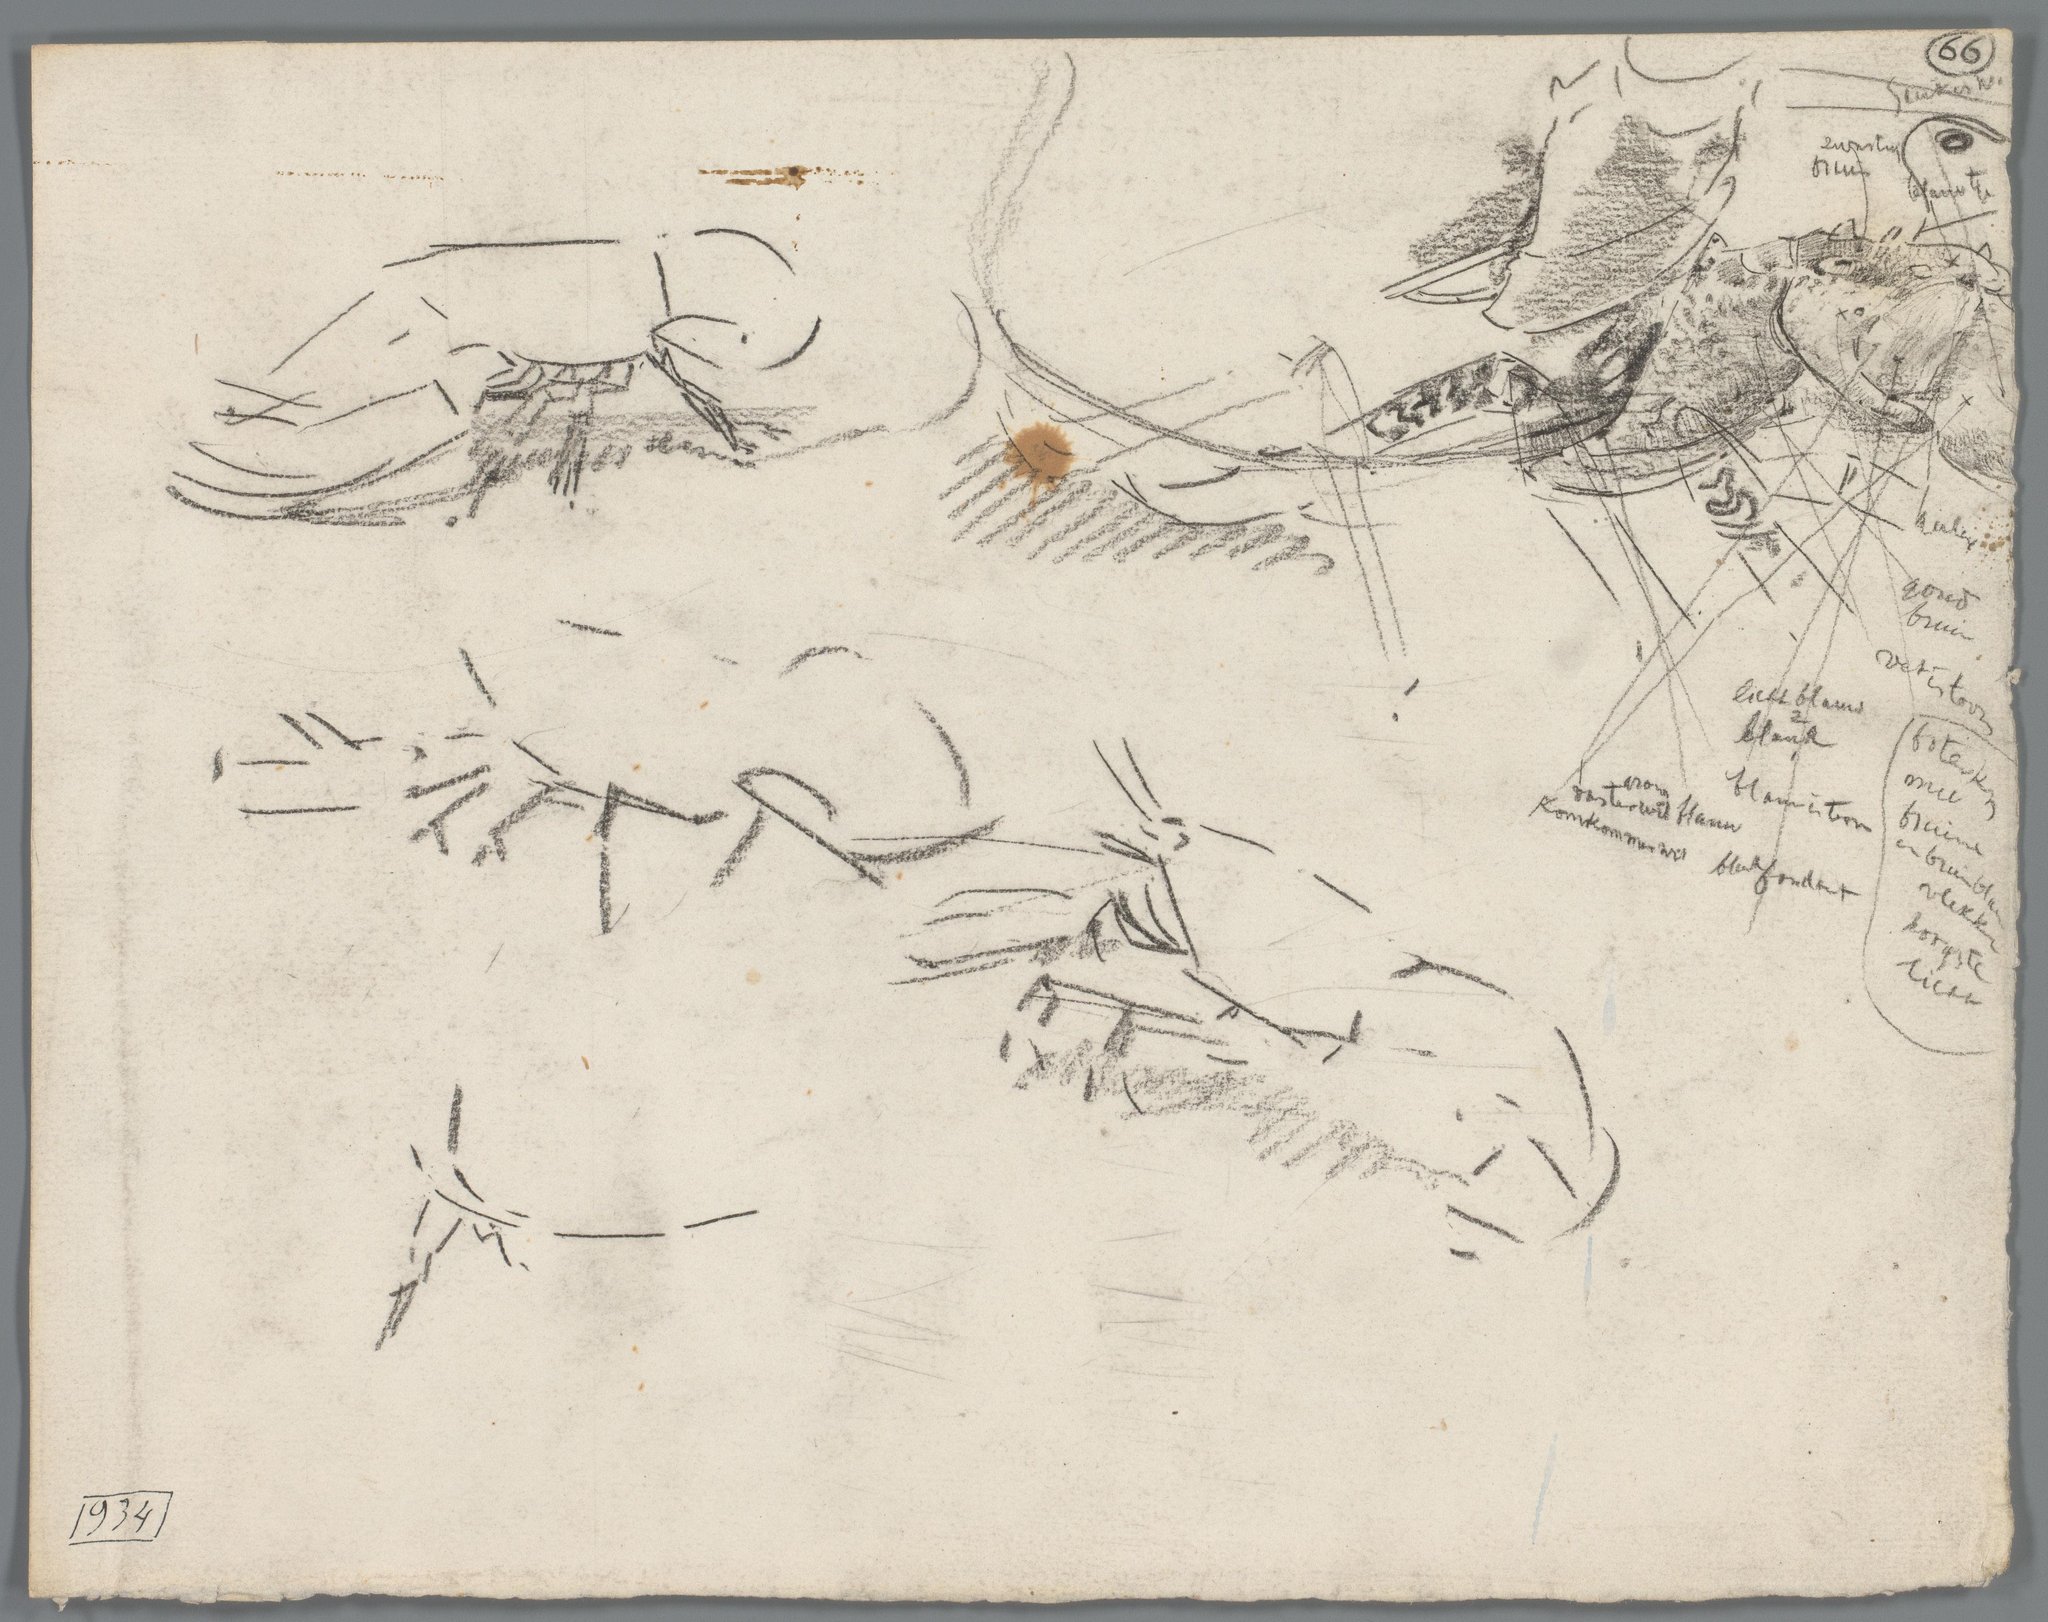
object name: drawing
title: Studies van kreeften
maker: gerrit willem dijsselhof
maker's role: designer, draughtsman, print maker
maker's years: 1866-1924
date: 1876-1924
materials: chalk, paper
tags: crustaceans: lobster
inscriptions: number: ‘66’, number: ‘934’